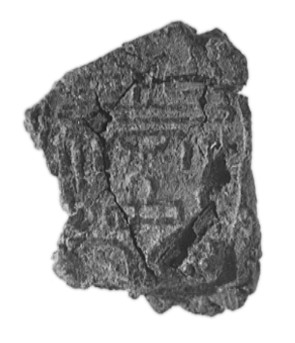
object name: sealing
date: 2030-1640 BCE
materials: clay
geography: egypt